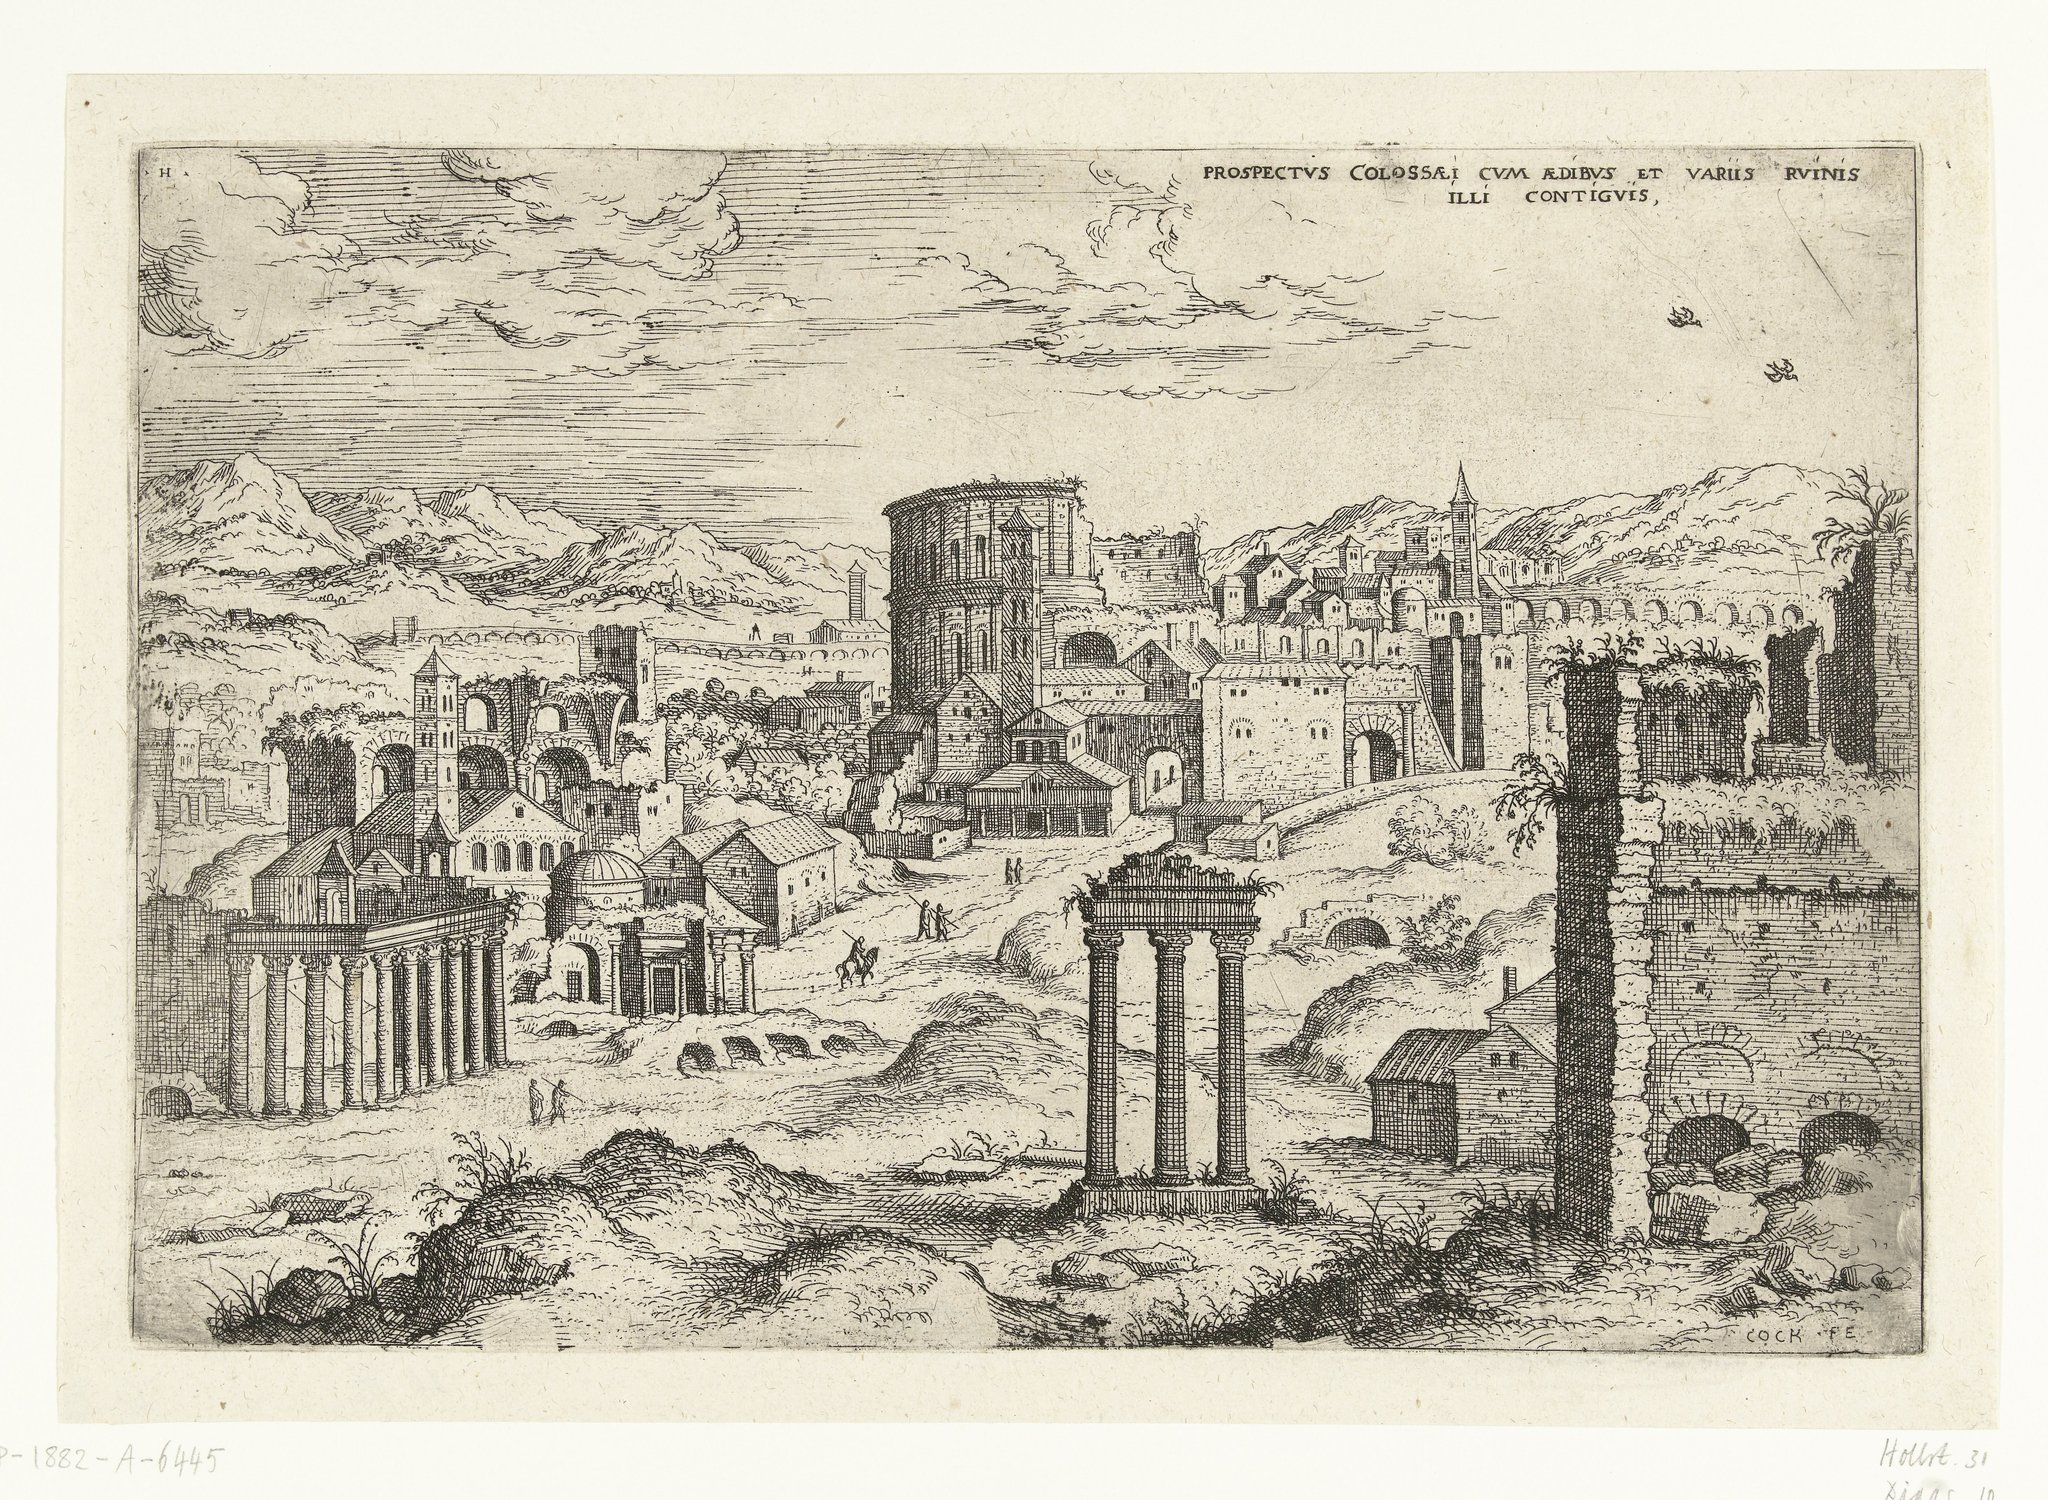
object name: print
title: Gezicht op het Forum Romanum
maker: hieronymus cock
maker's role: print maker, publisher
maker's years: 1518-1570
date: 1551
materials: paper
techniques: etching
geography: antwerp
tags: ruin of a building ~ architecture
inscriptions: collector's mark: Lugt 2228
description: Gezicht op het Forum Romanum in Rome met ruïnes van historische gebouwen. Prent uit een serie van 25 prenten met Romeinse ruïnes.